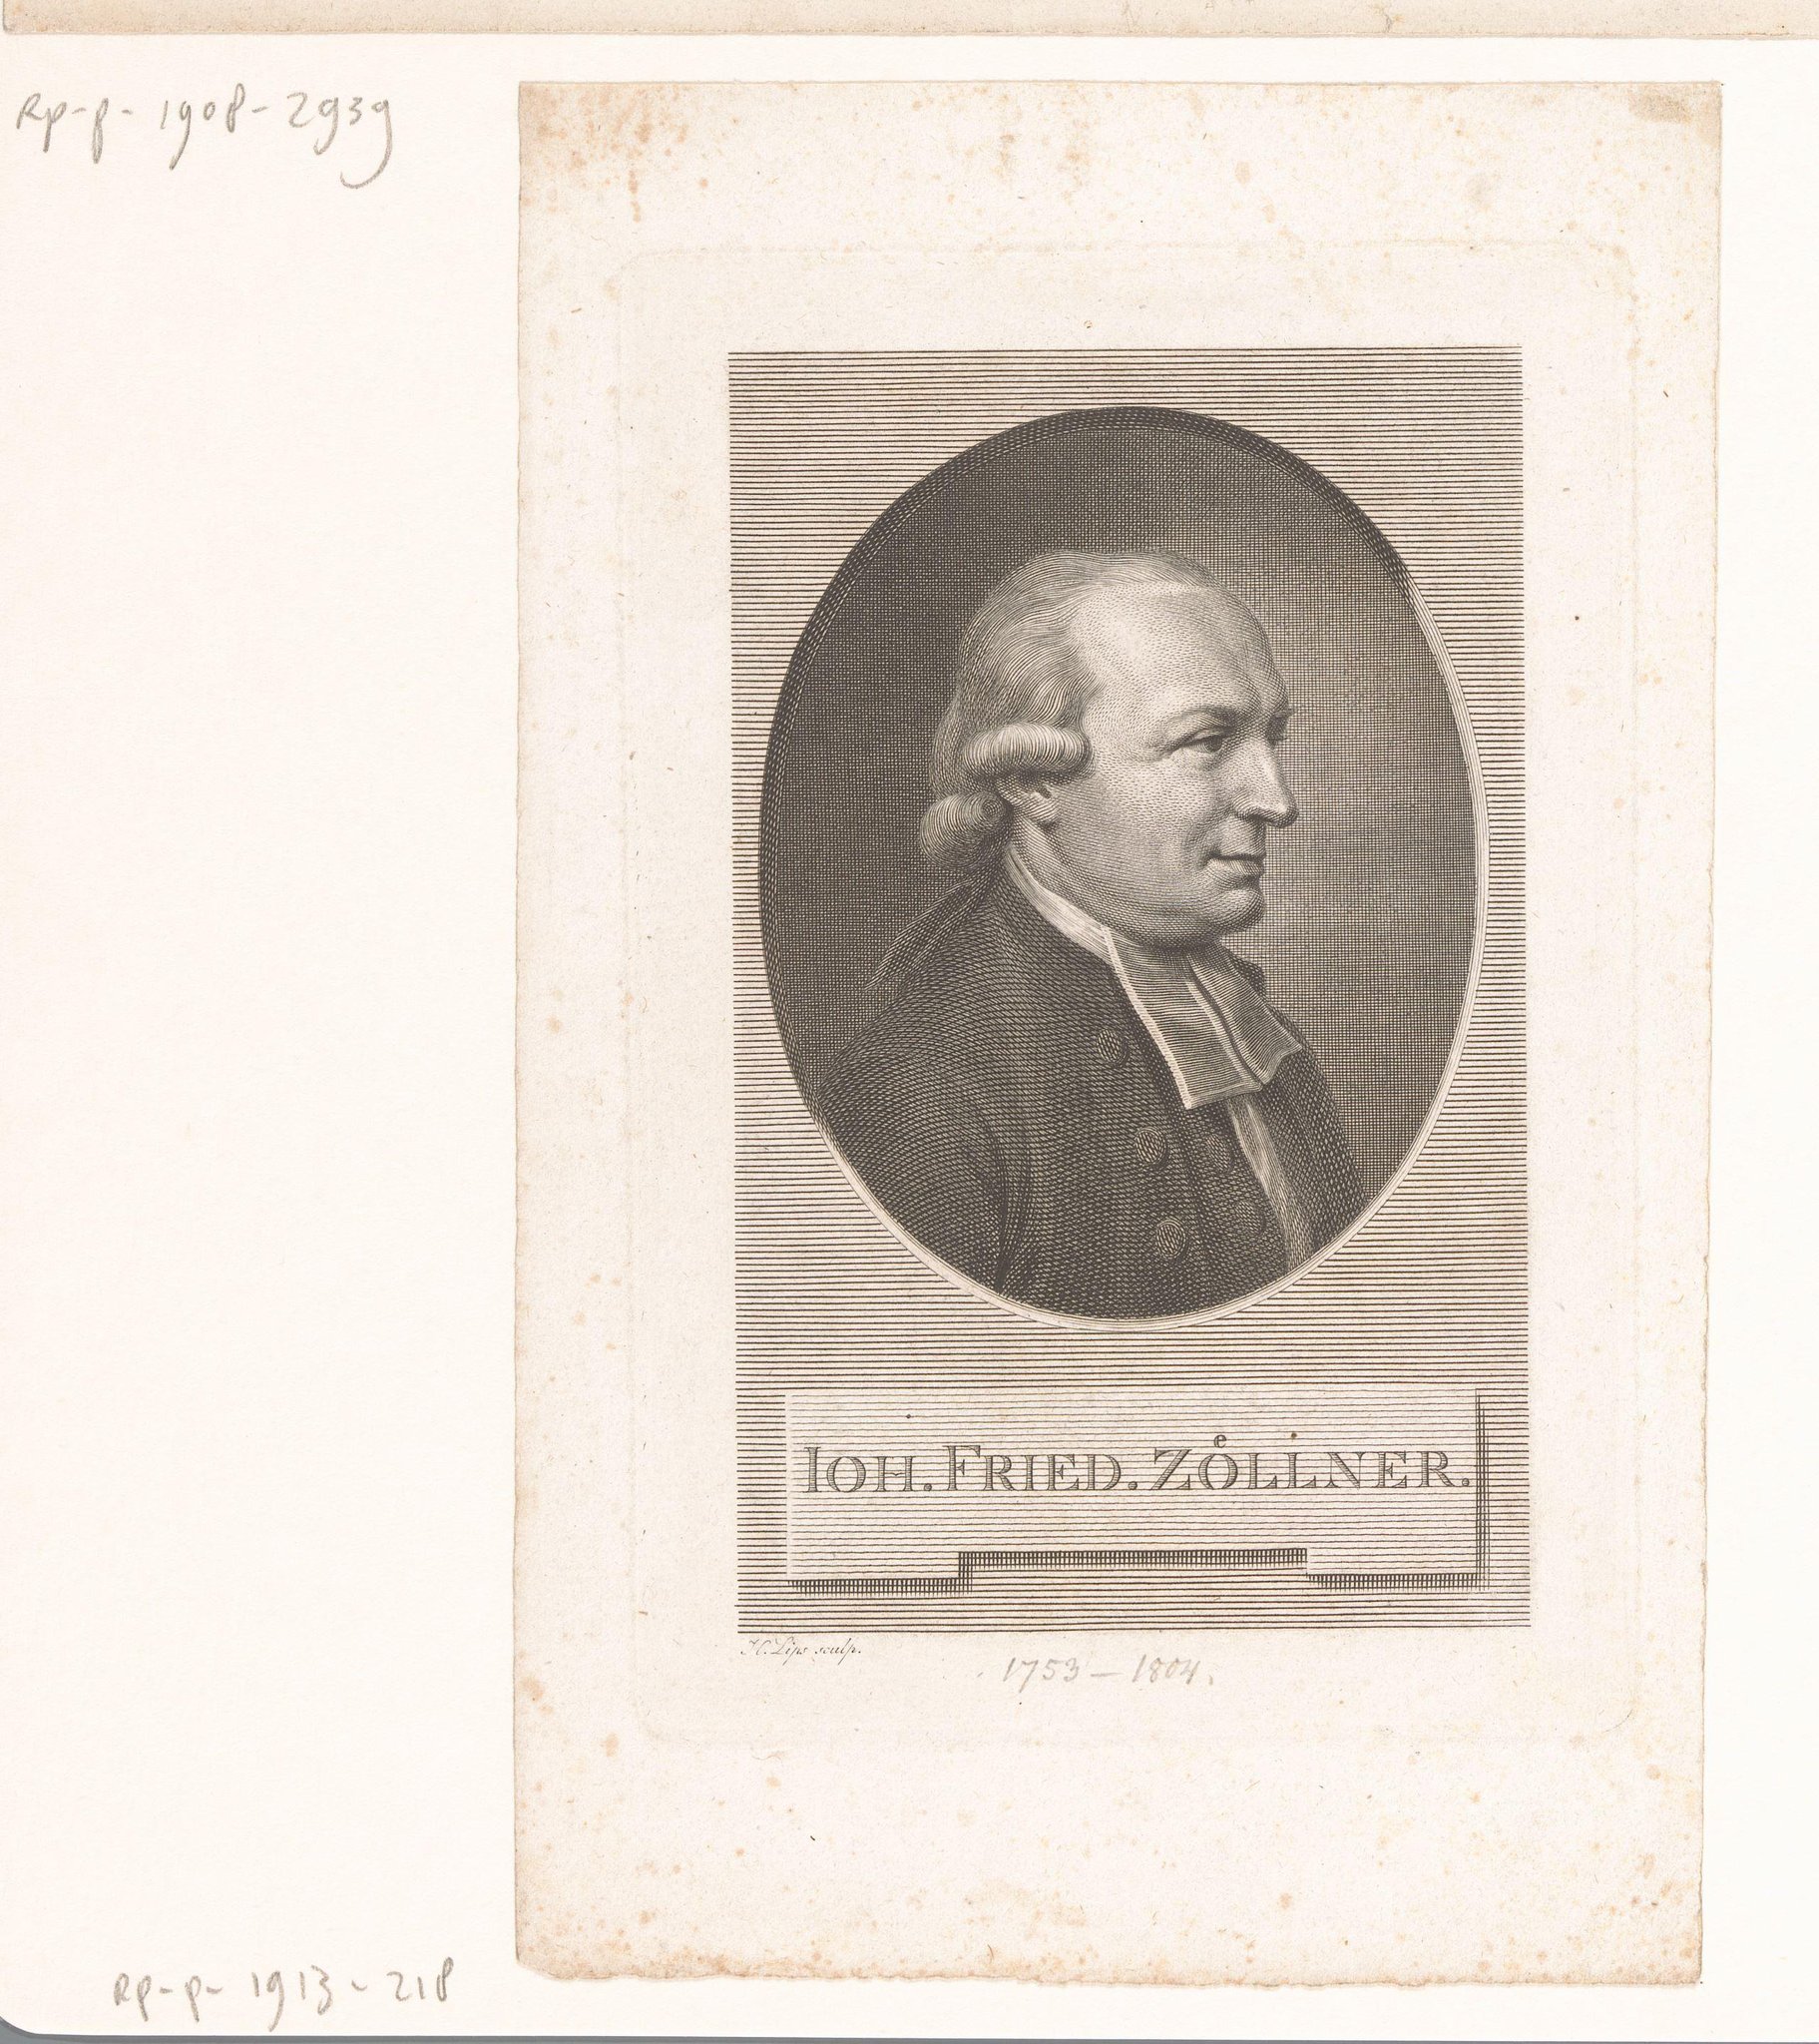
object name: print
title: Portret van Johann Friedrich Zöllner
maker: johann heinrich lips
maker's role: draughtsman, painter, print maker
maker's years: 1758-1817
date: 1768-1817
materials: paper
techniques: engraving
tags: theologian, historical persons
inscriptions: collector's mark: Lugt 2228, number